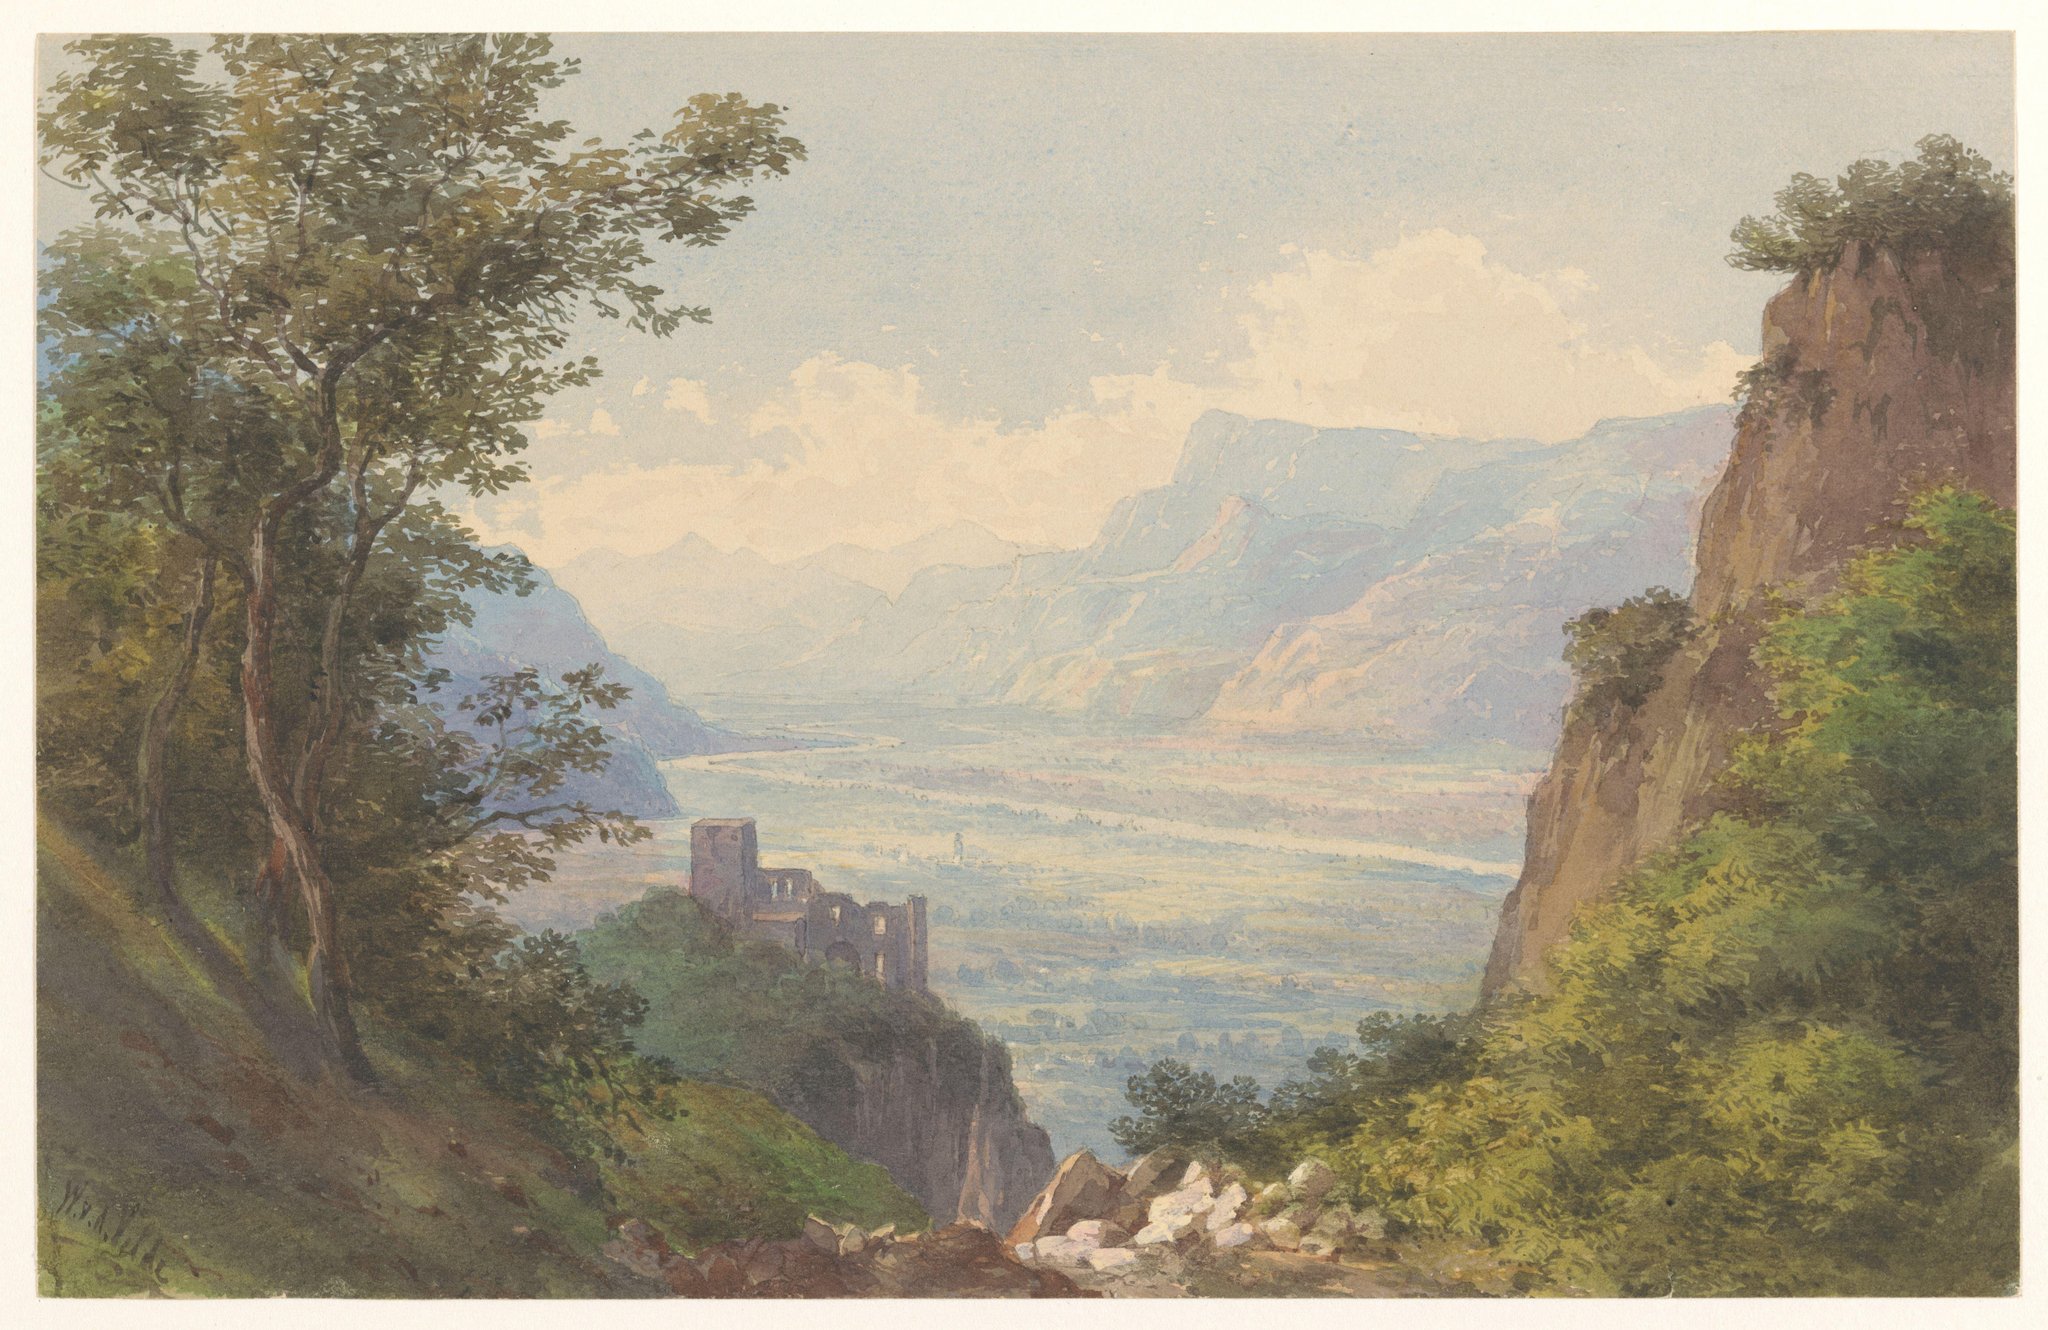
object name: drawing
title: Gezicht op de vallei van Meran in Tirol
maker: charles william meredith van de velde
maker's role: draughtsman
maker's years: 1818-1898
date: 1828-1892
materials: chalk, paper, watercolor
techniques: brush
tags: dale, valley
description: Gezicht op de vallei van Meran in Tirol met zicht op ruïne Brunnenburg en het dorp Tirol.